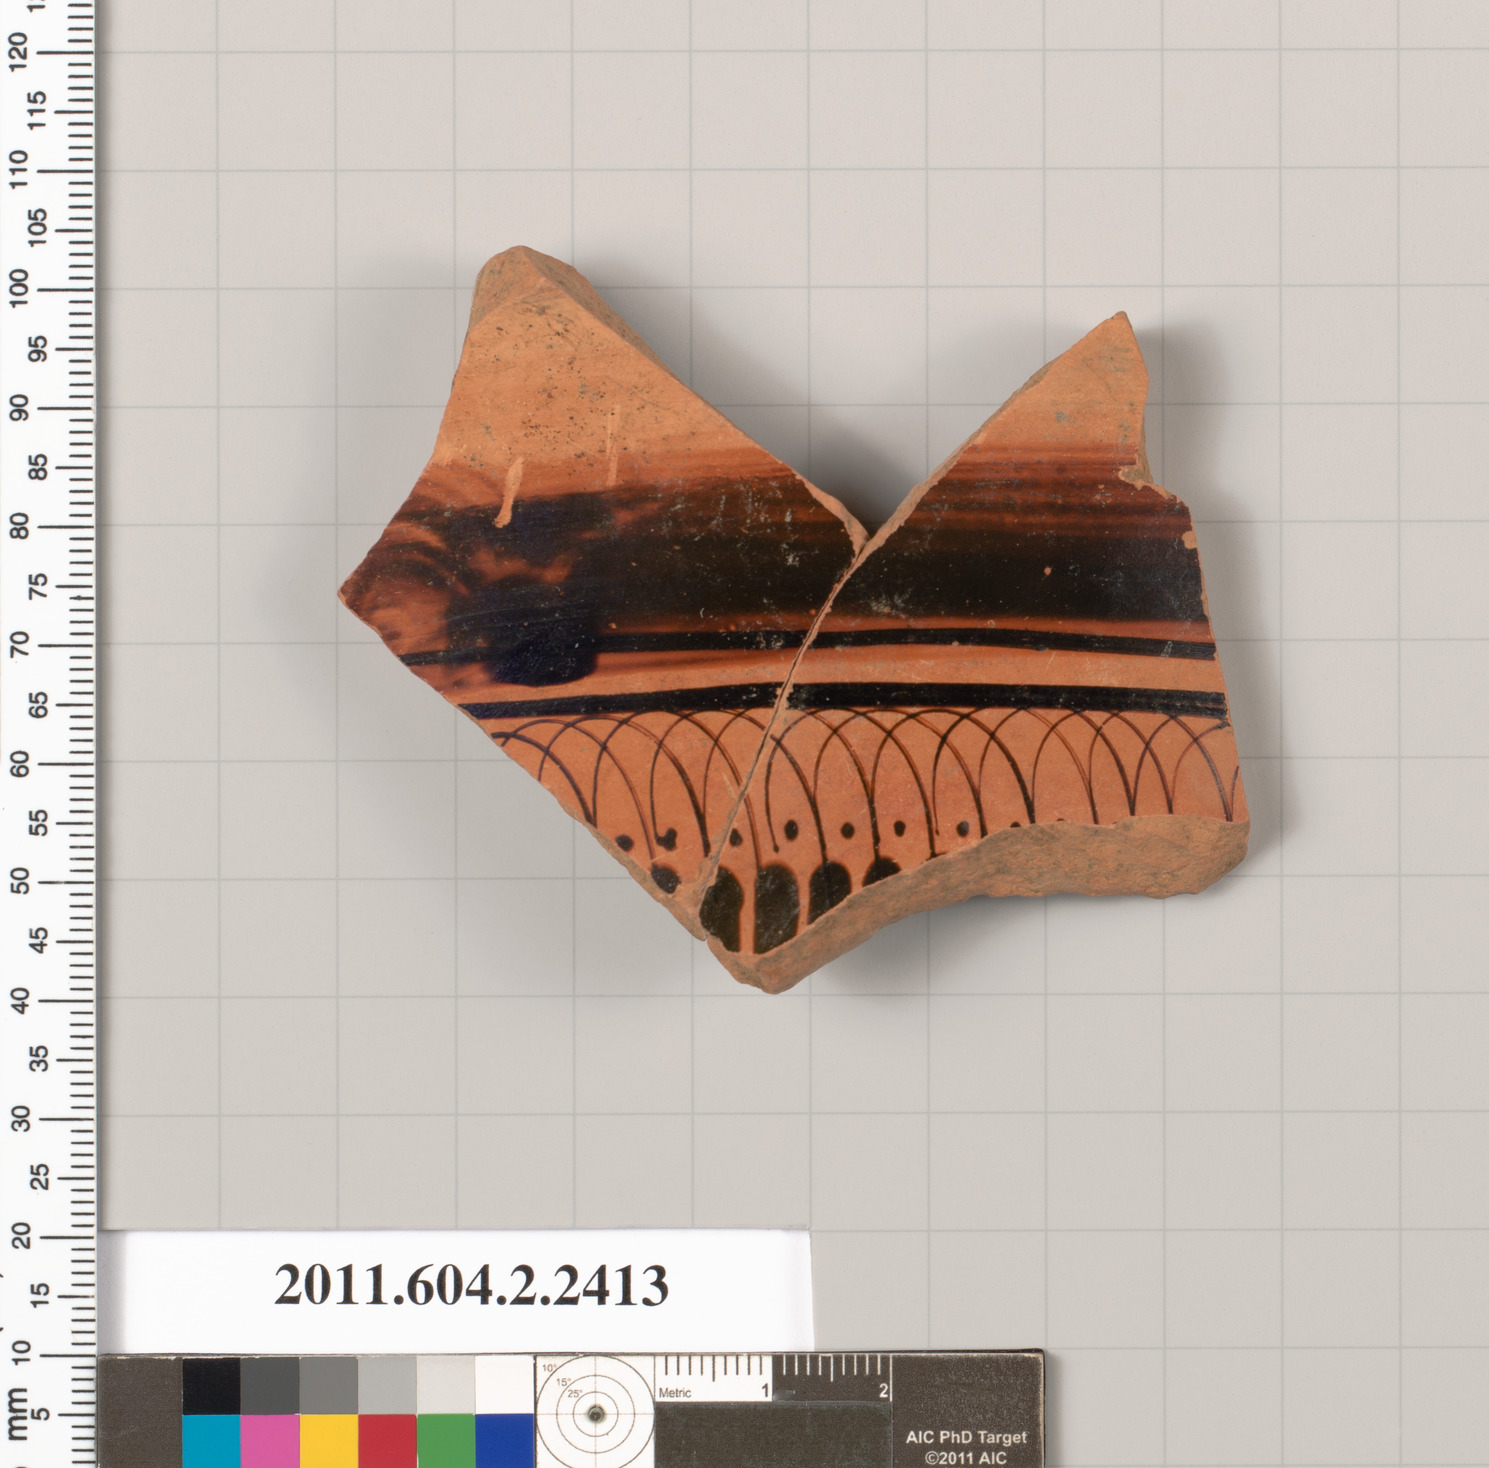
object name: column krater fragment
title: Terracotta fragment of a column-krater (bowl for mixing wine and water)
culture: greek, attic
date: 450-426 BCE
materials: terracotta